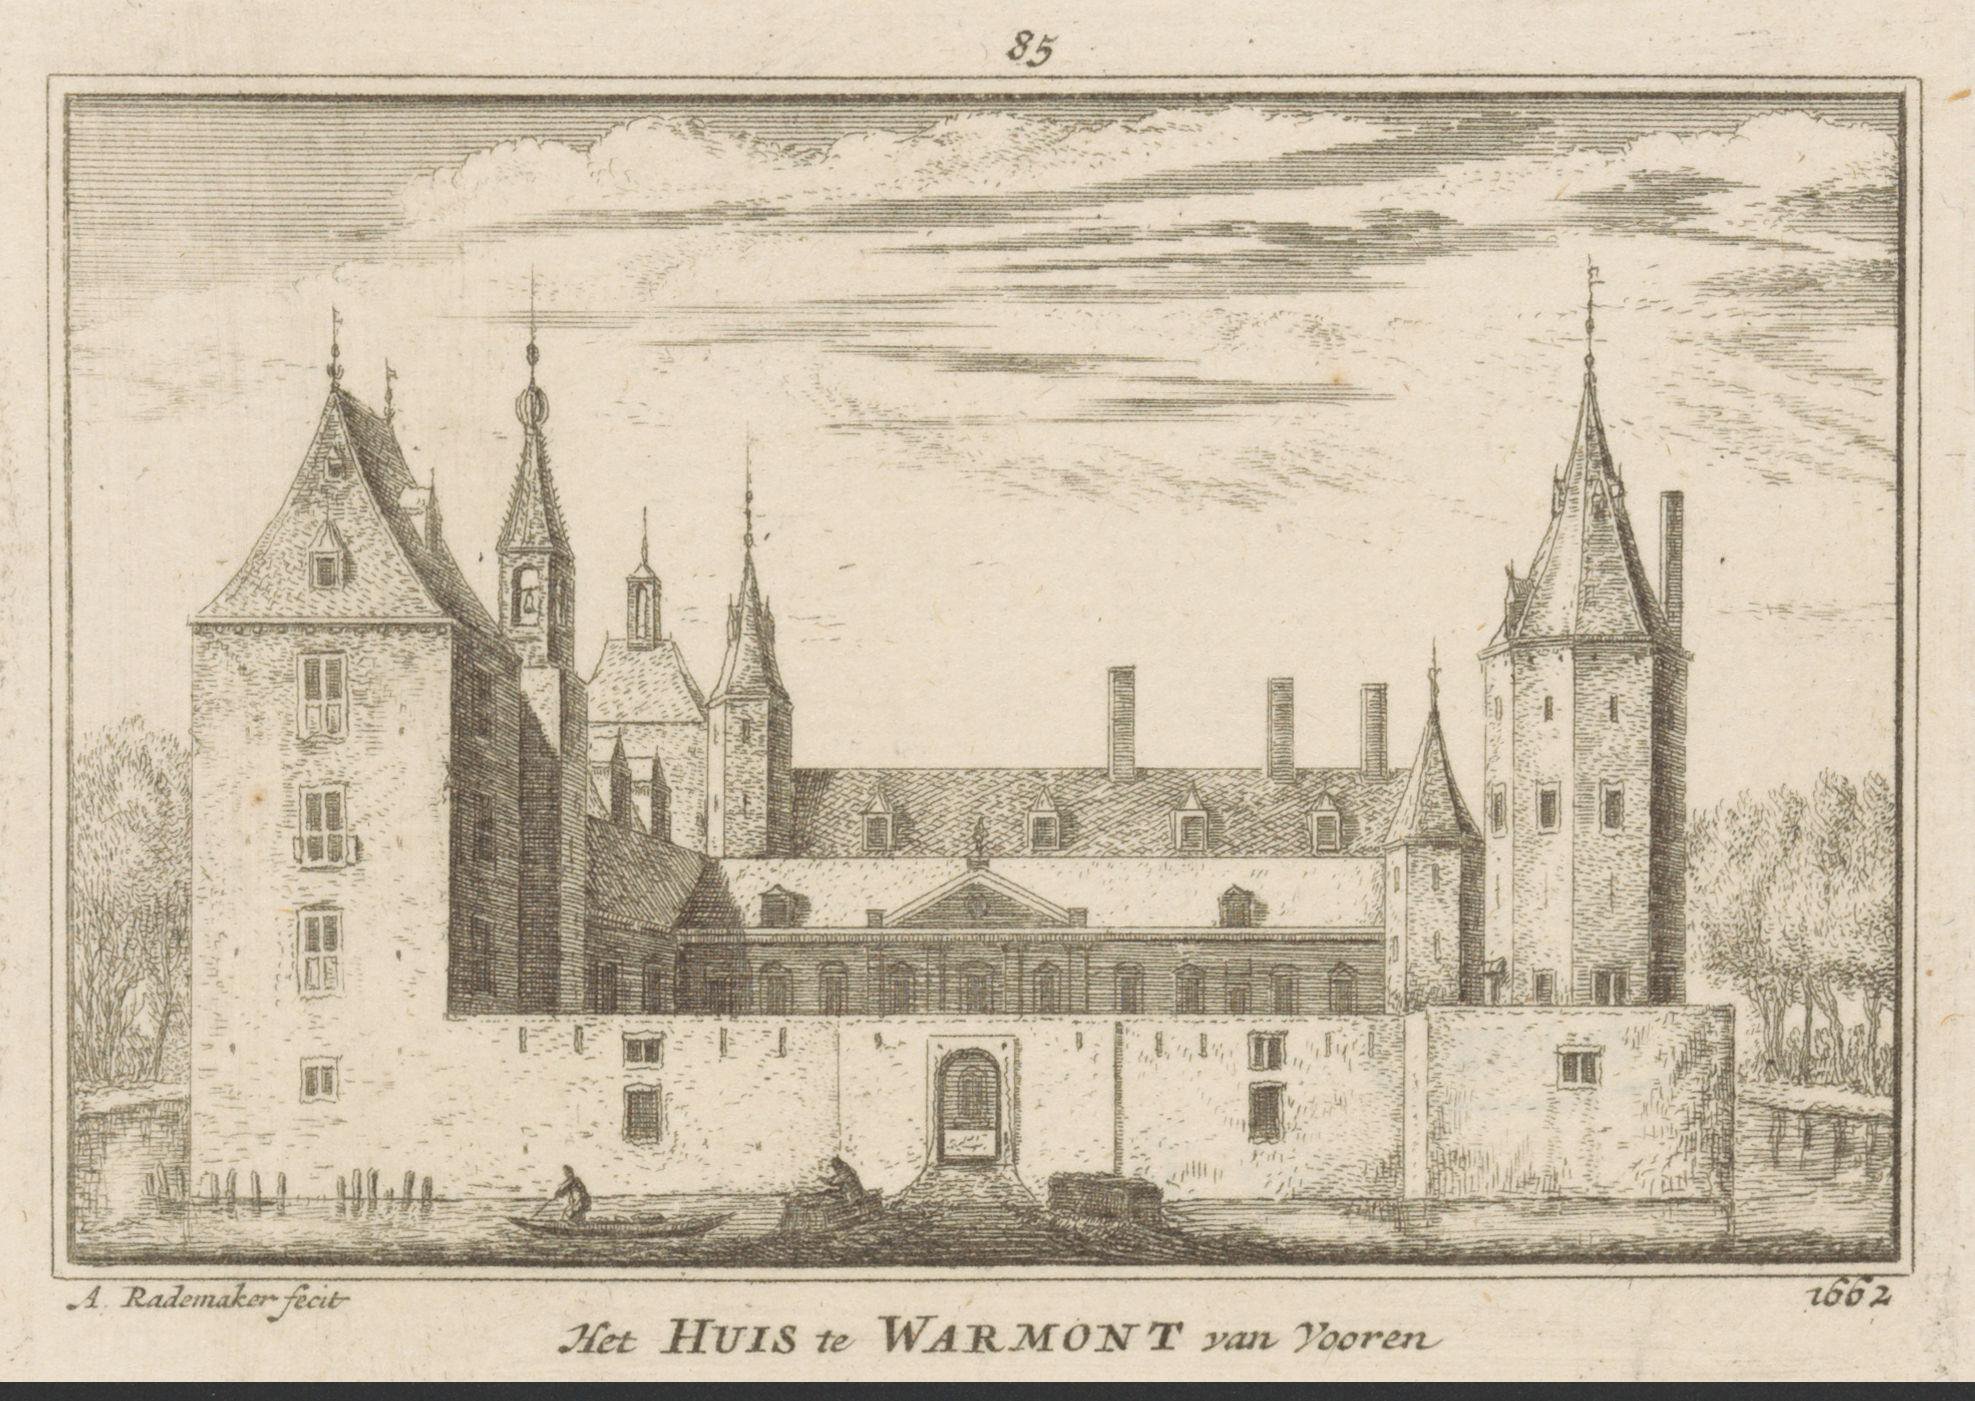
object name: book illustration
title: Het Huis te Warmont van vooren 1662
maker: abraham rademaker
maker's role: draughtsman, print maker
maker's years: 1676-1735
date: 1725-1803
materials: paper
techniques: engraving, etching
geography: amsterdam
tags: castle, bridge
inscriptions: collector's mark: Lugt 2228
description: Prent ook gebruikt in: Rademaker, Abraham. Kabinet van Nederlandsche outheden en gezichten: vervat in 300 konstplaaten (…). 2 delen. Amsterdam: Willem Barents, 1725, dl. 1, ill. 85. Na 1725 is deze prent nog in verschillende heruitgaven verschenen, uitgegeven in 1727-1733, 1770-1771 en 1792-1803. Uit welke uitgave het huidige exemplaar precies komt is niet na te gaan.